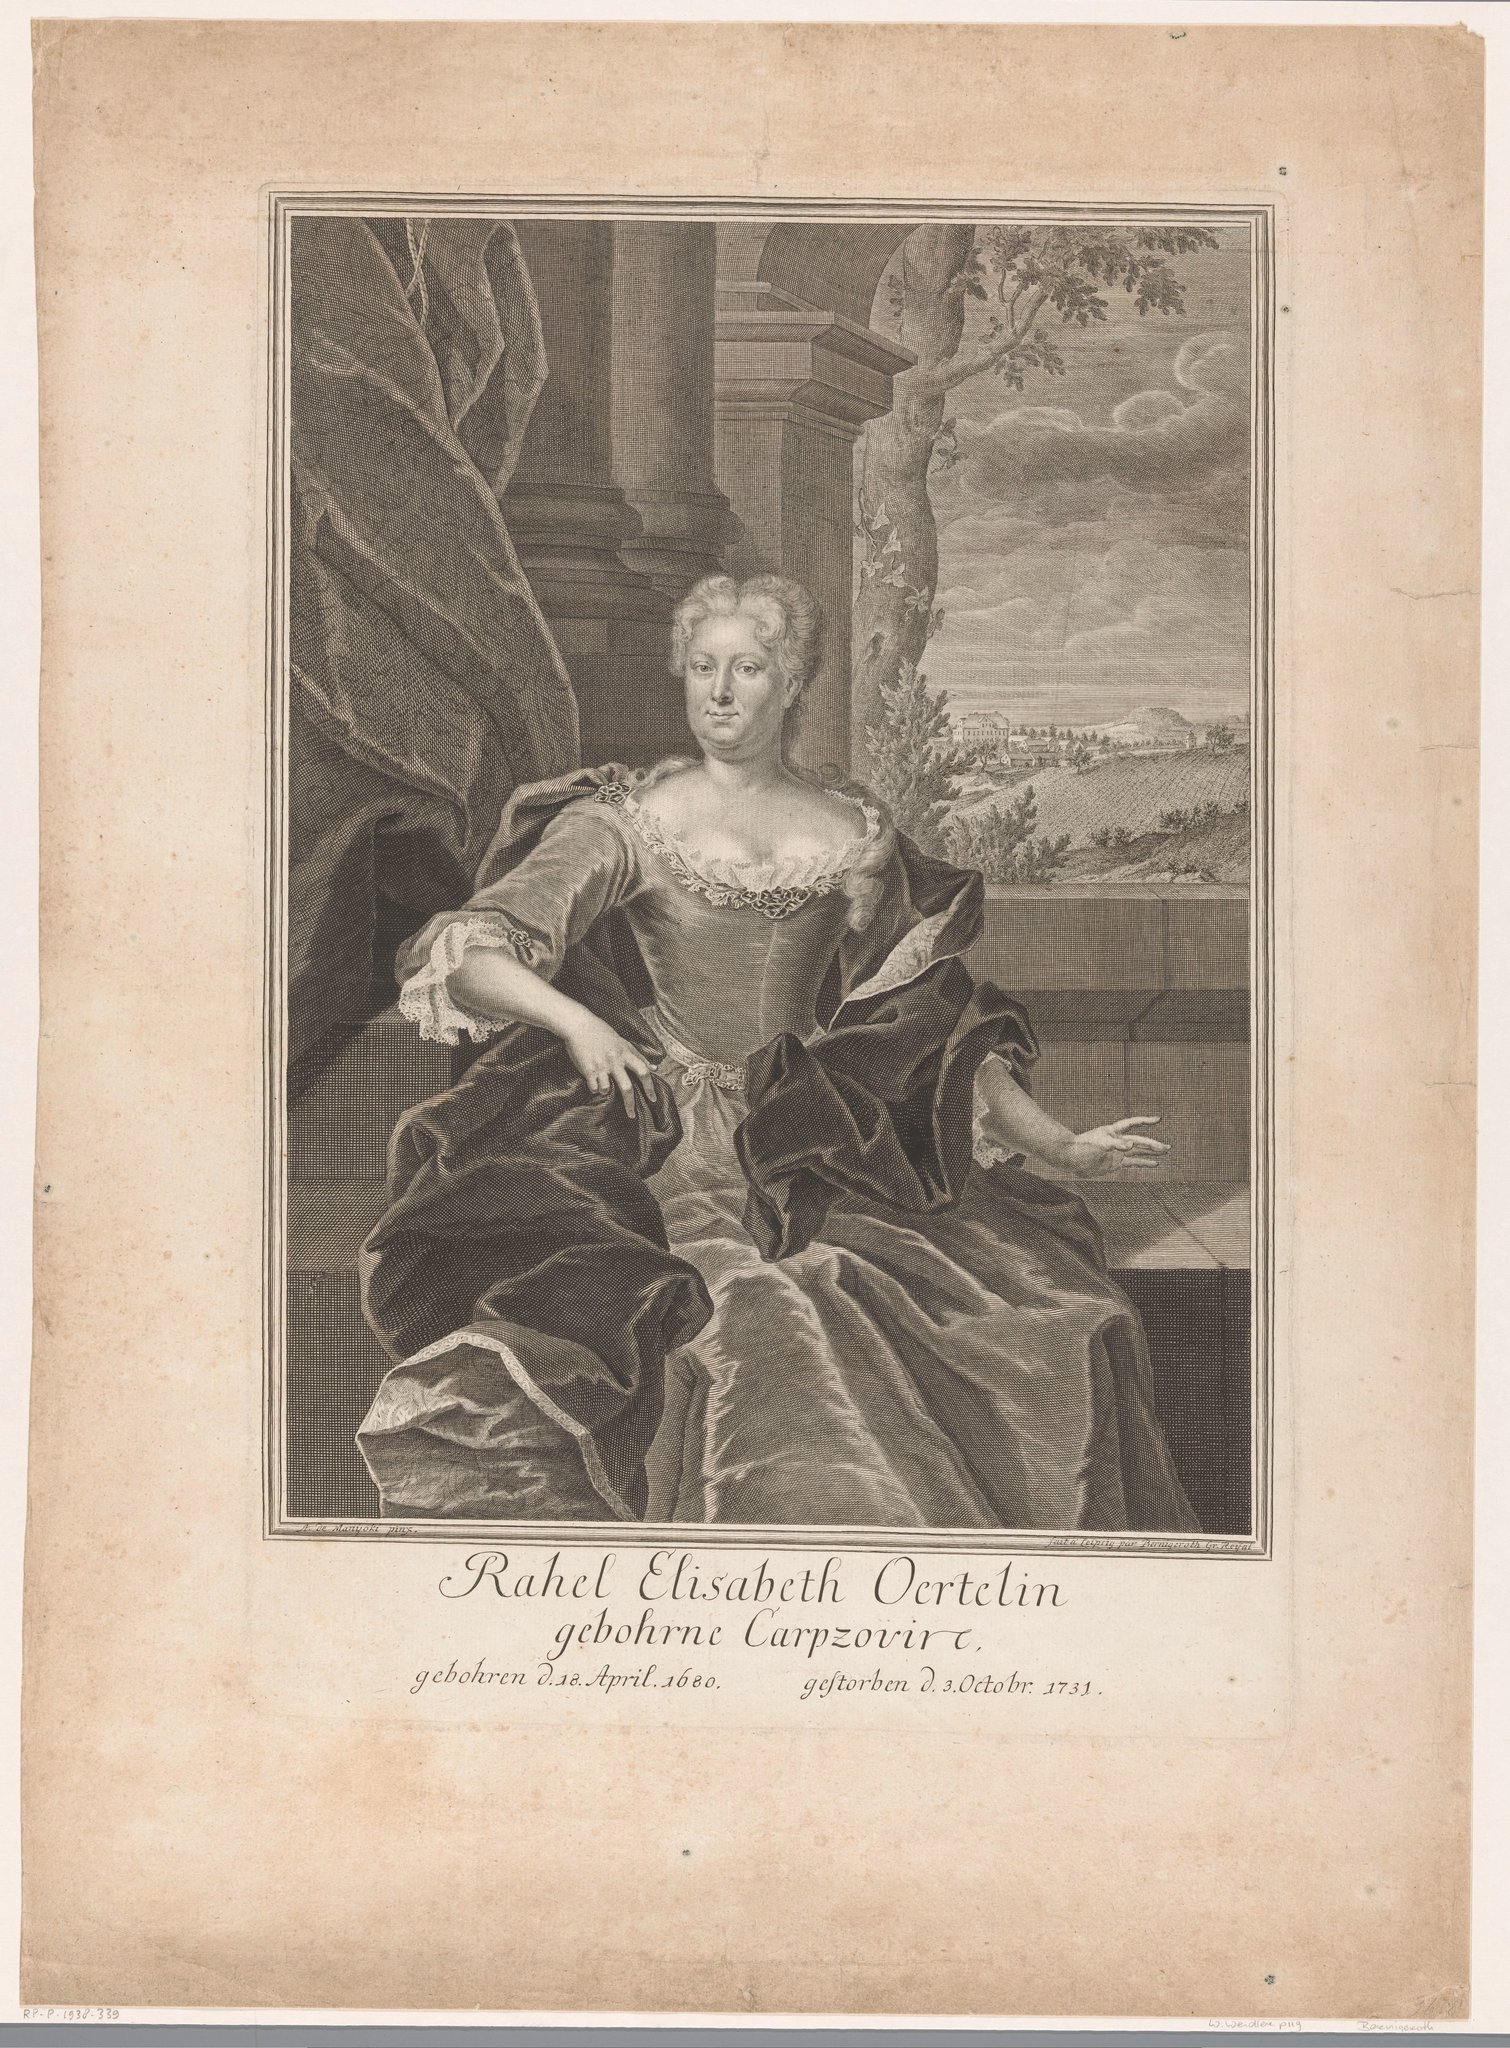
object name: print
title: Portret van Rahel Elisabeth Oertel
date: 1731-1733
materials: paper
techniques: engraving, etching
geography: leipzig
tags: prospect of village, silhouette of village, historical persons - bb - woman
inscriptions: collector's mark: Lugt 2228